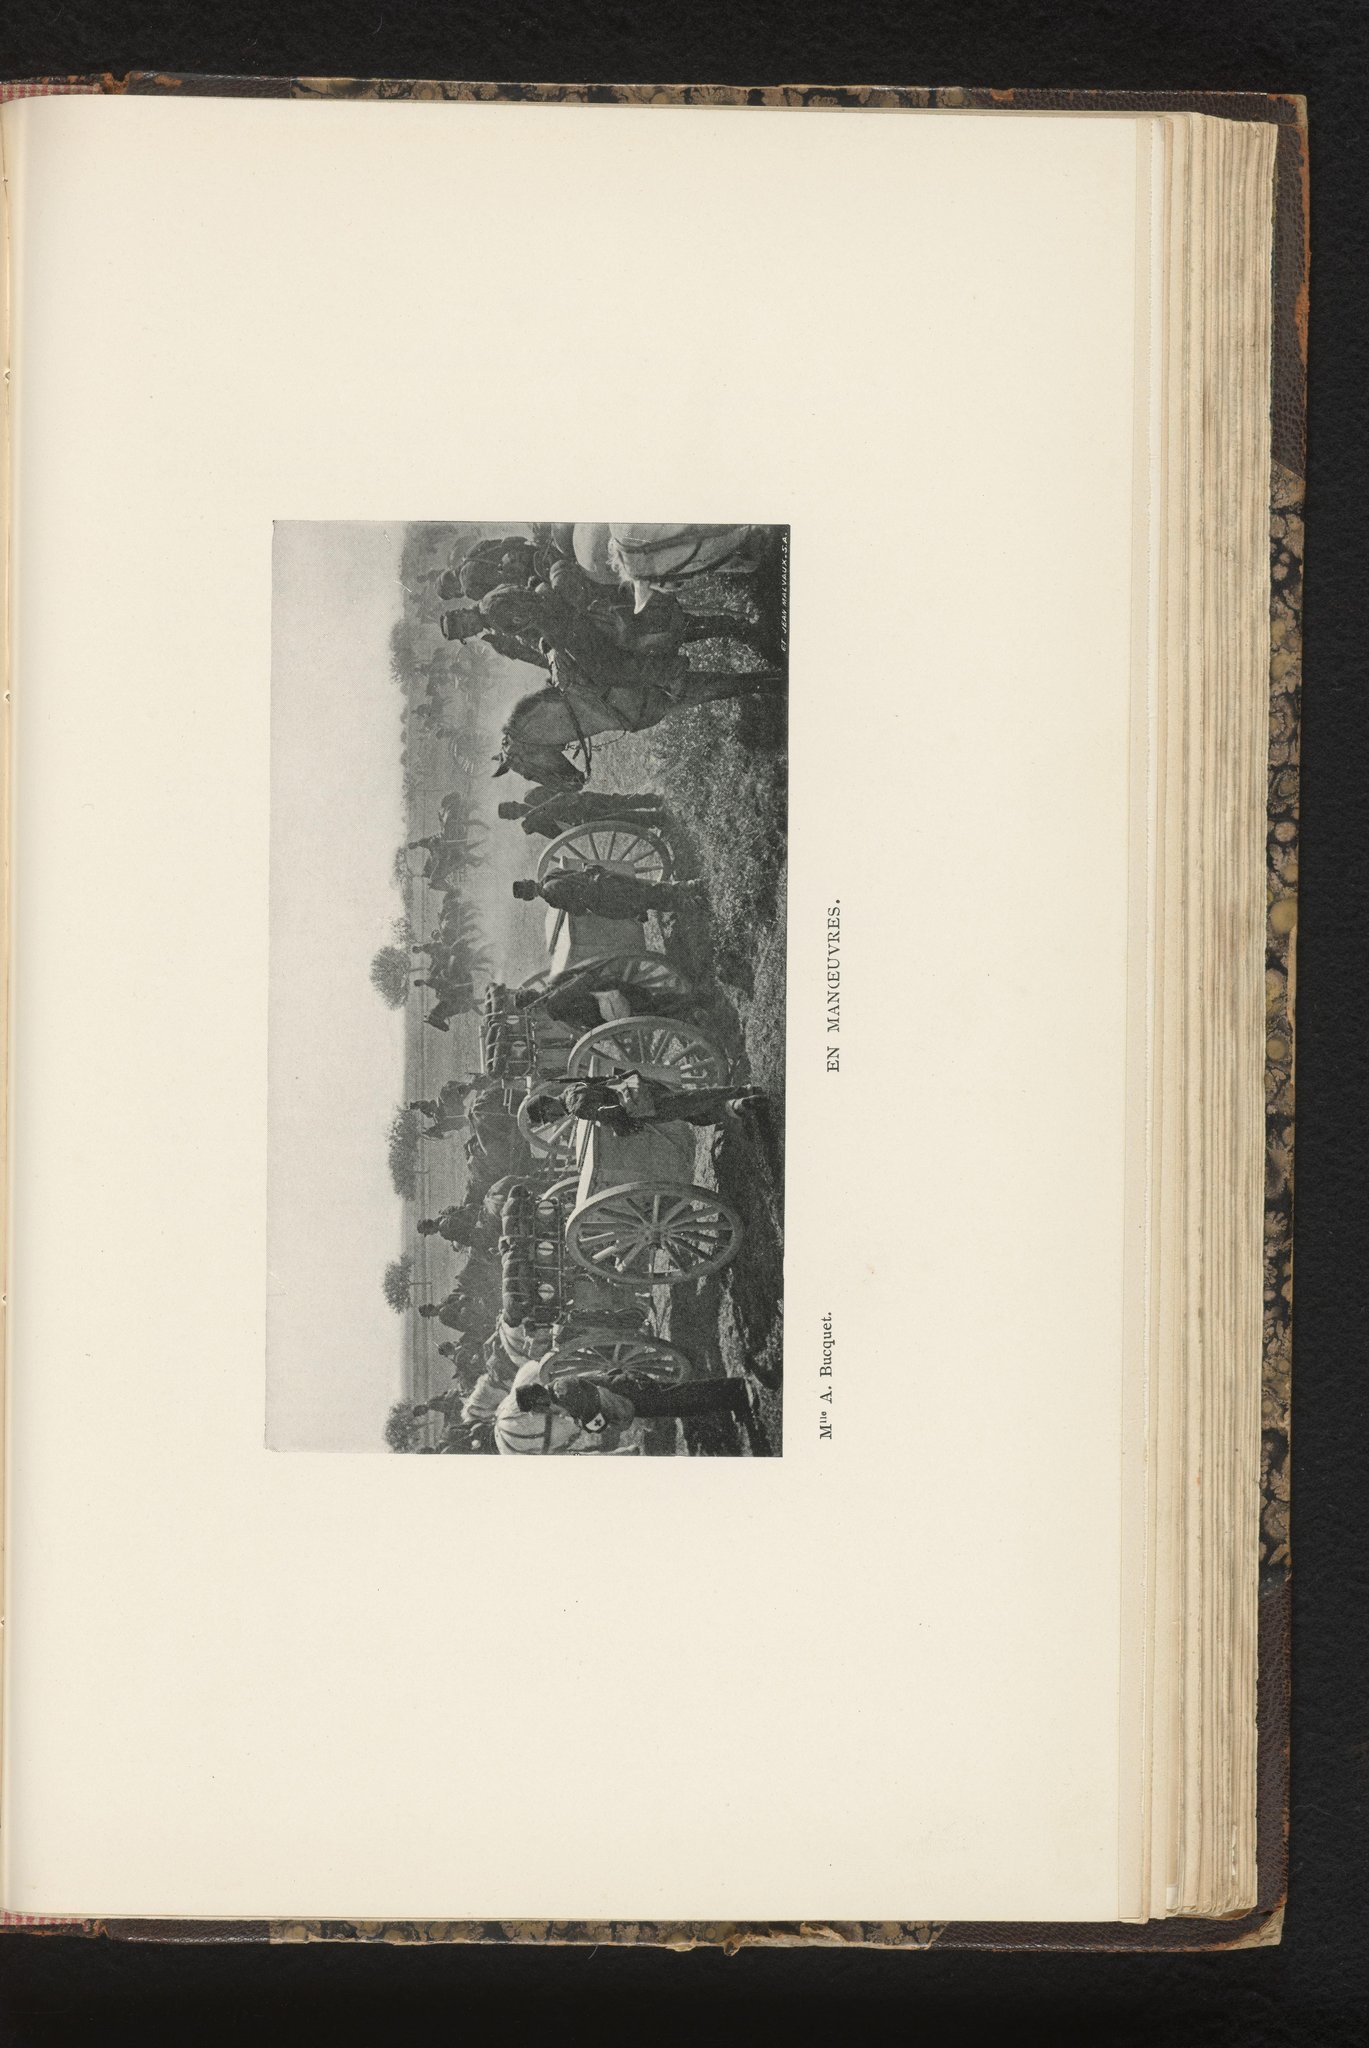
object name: page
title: En manoeuvre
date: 1897-1902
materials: paper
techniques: autotype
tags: warfare; military affairs, horse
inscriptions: inscription: ‘Mlle Bucquet’